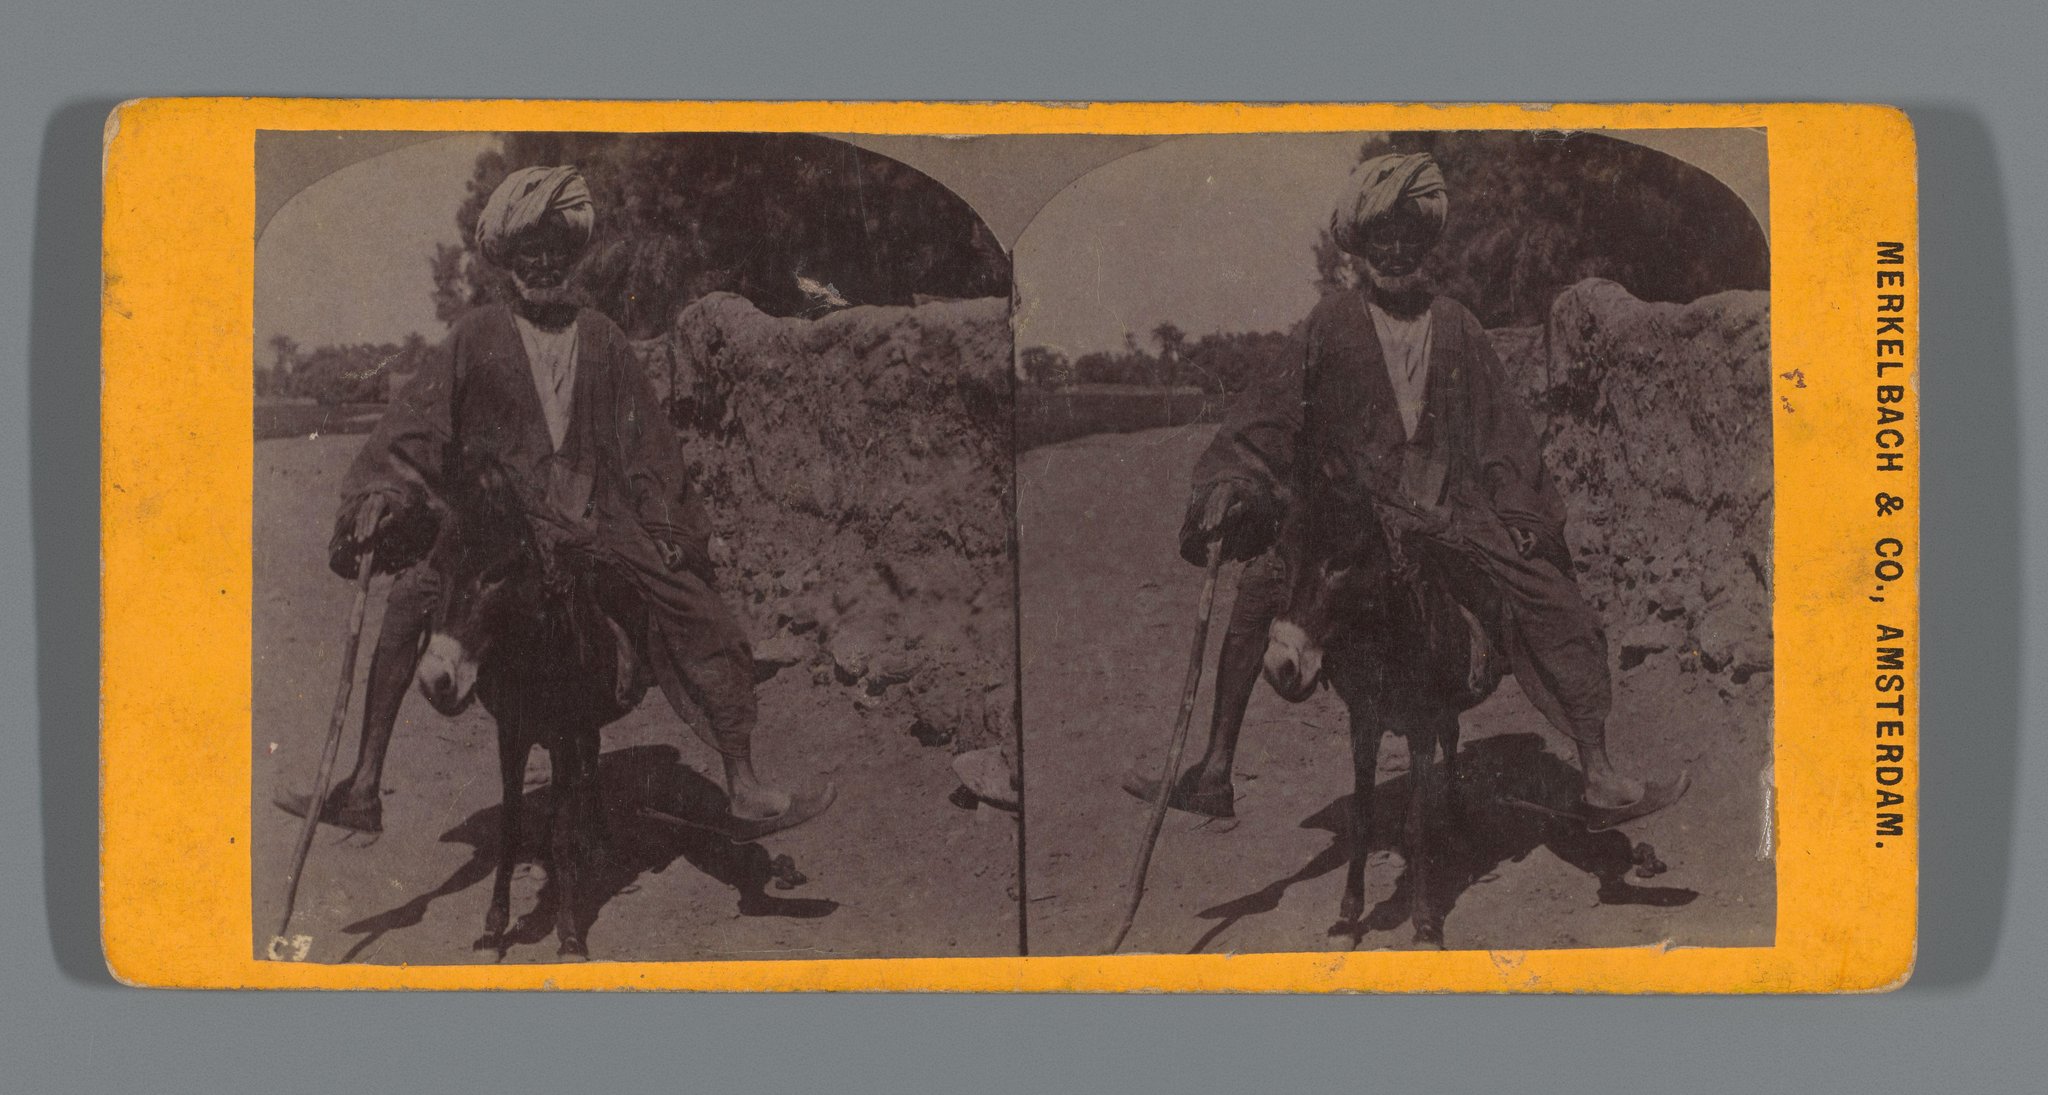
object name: stereograph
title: Aardrijkskundige Beeldengalerij, verzameld door M.J. Broekhuijsen, Hoofd eener school te Amsterdam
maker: martien johan broekhuijsen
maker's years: 1871-1956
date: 1905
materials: photographic support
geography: amsterdam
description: Onderdeel van een groep van 52 stereofoto's gebruikt in het lager onderwijs als aanvulling op schoolplaten. De gehele reeks bestond uit 274 nummers in 10 categorieën (A t/m K).